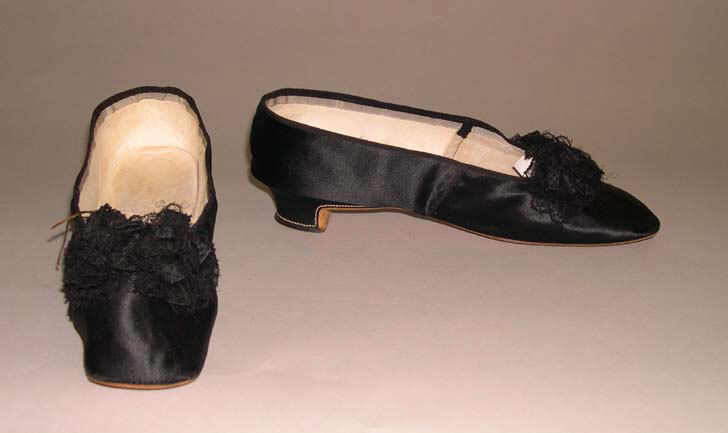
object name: slipper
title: Slippers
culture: french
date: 1850-1859